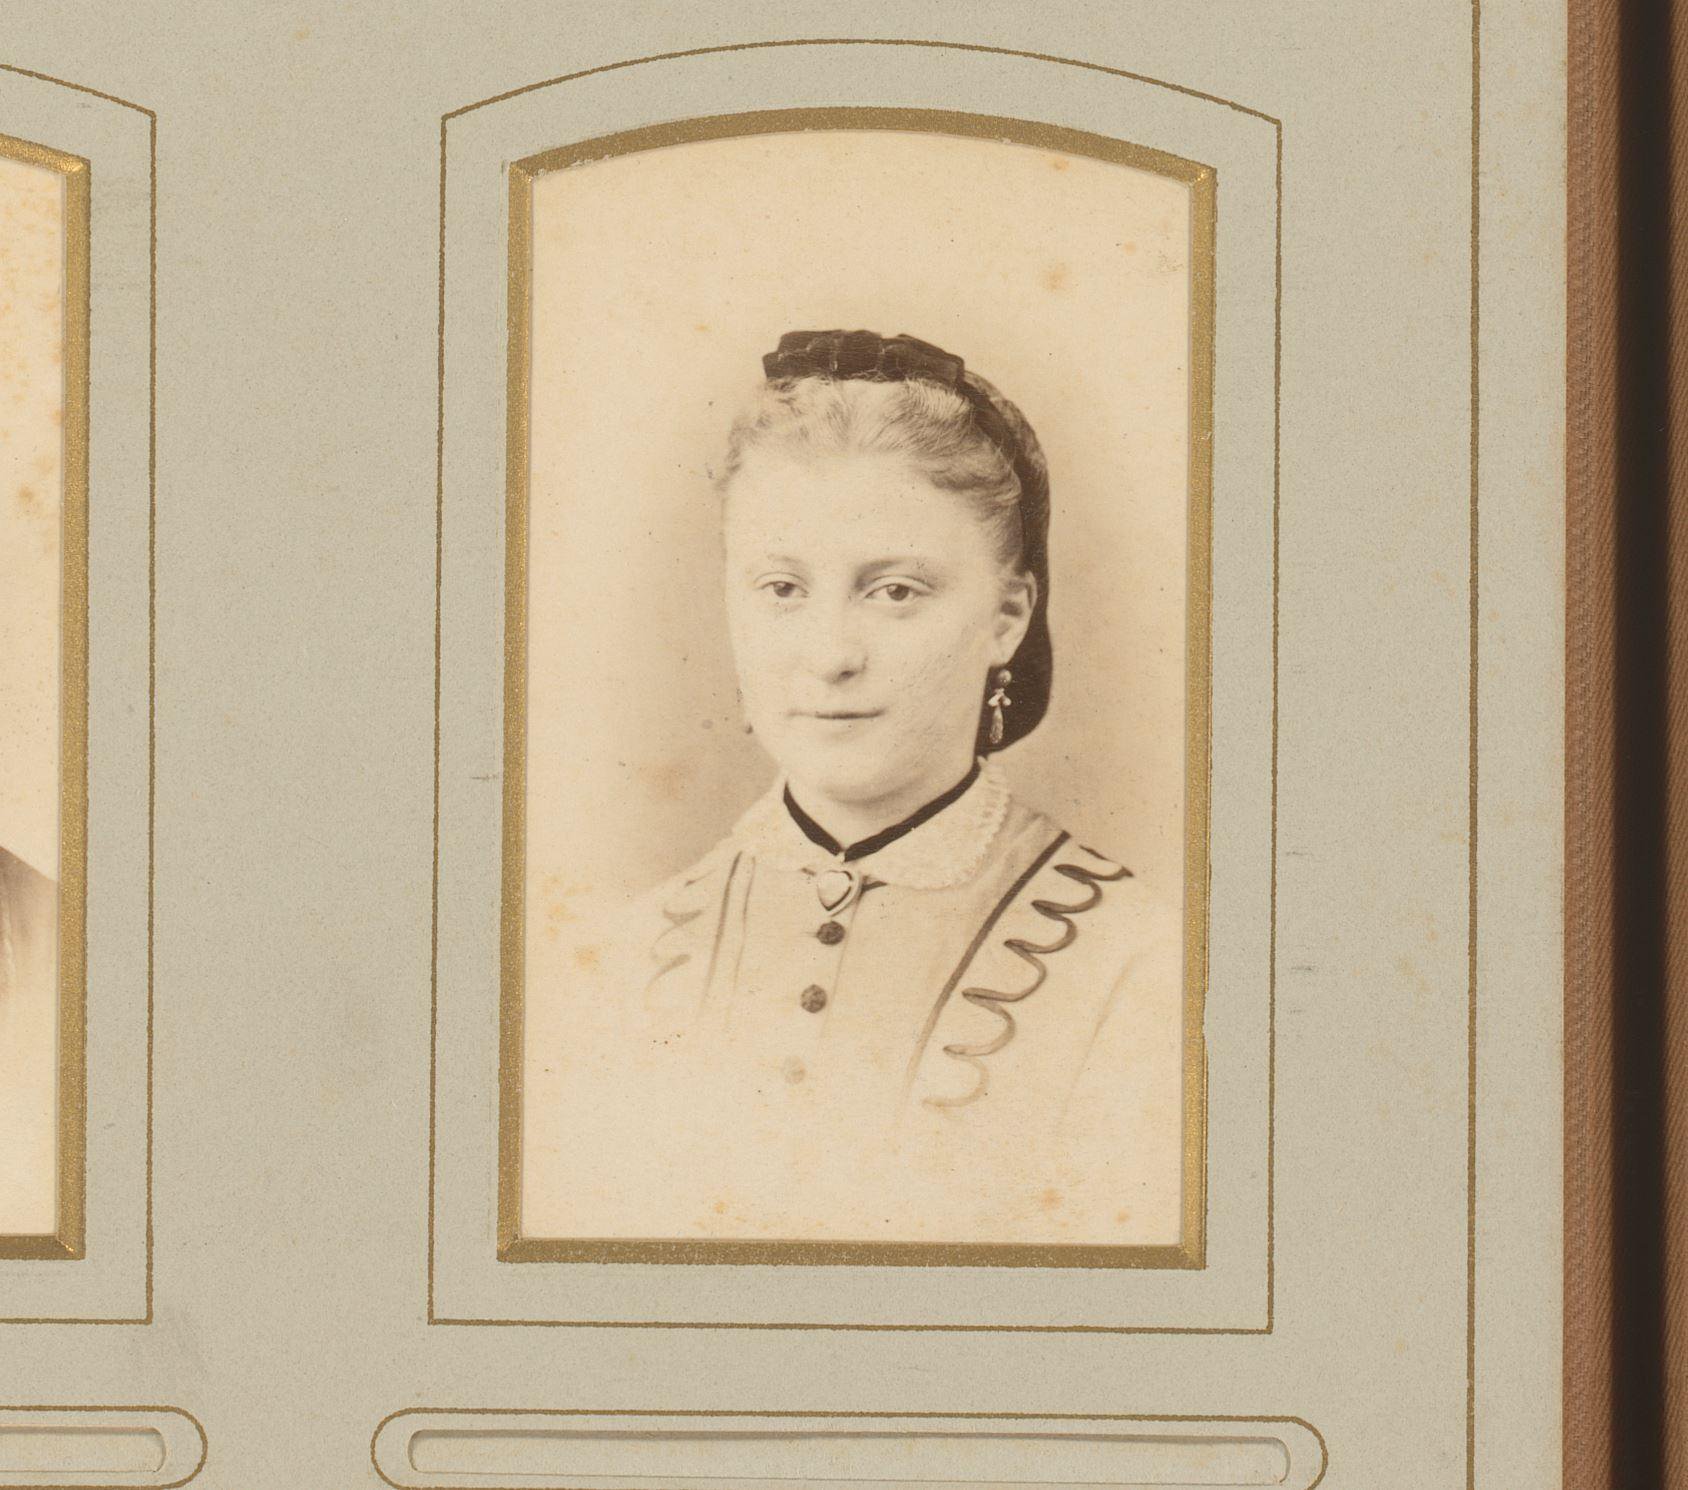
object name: album leaf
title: Portret van een vrouw met halsketting en strik in het haar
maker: palmer descamps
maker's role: goldsmith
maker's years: 1840-1884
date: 1865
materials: cardboard, photographic support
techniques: albumen print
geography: kortrijk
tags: historical persons - bb - woman, hairdress, necklace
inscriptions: inscription: ‘COURTRAI/ RUE DE LA LYS, 13./ PHOTOGRAPHIE/ Descamps/ PALMER/ ORFÈVRERIE’